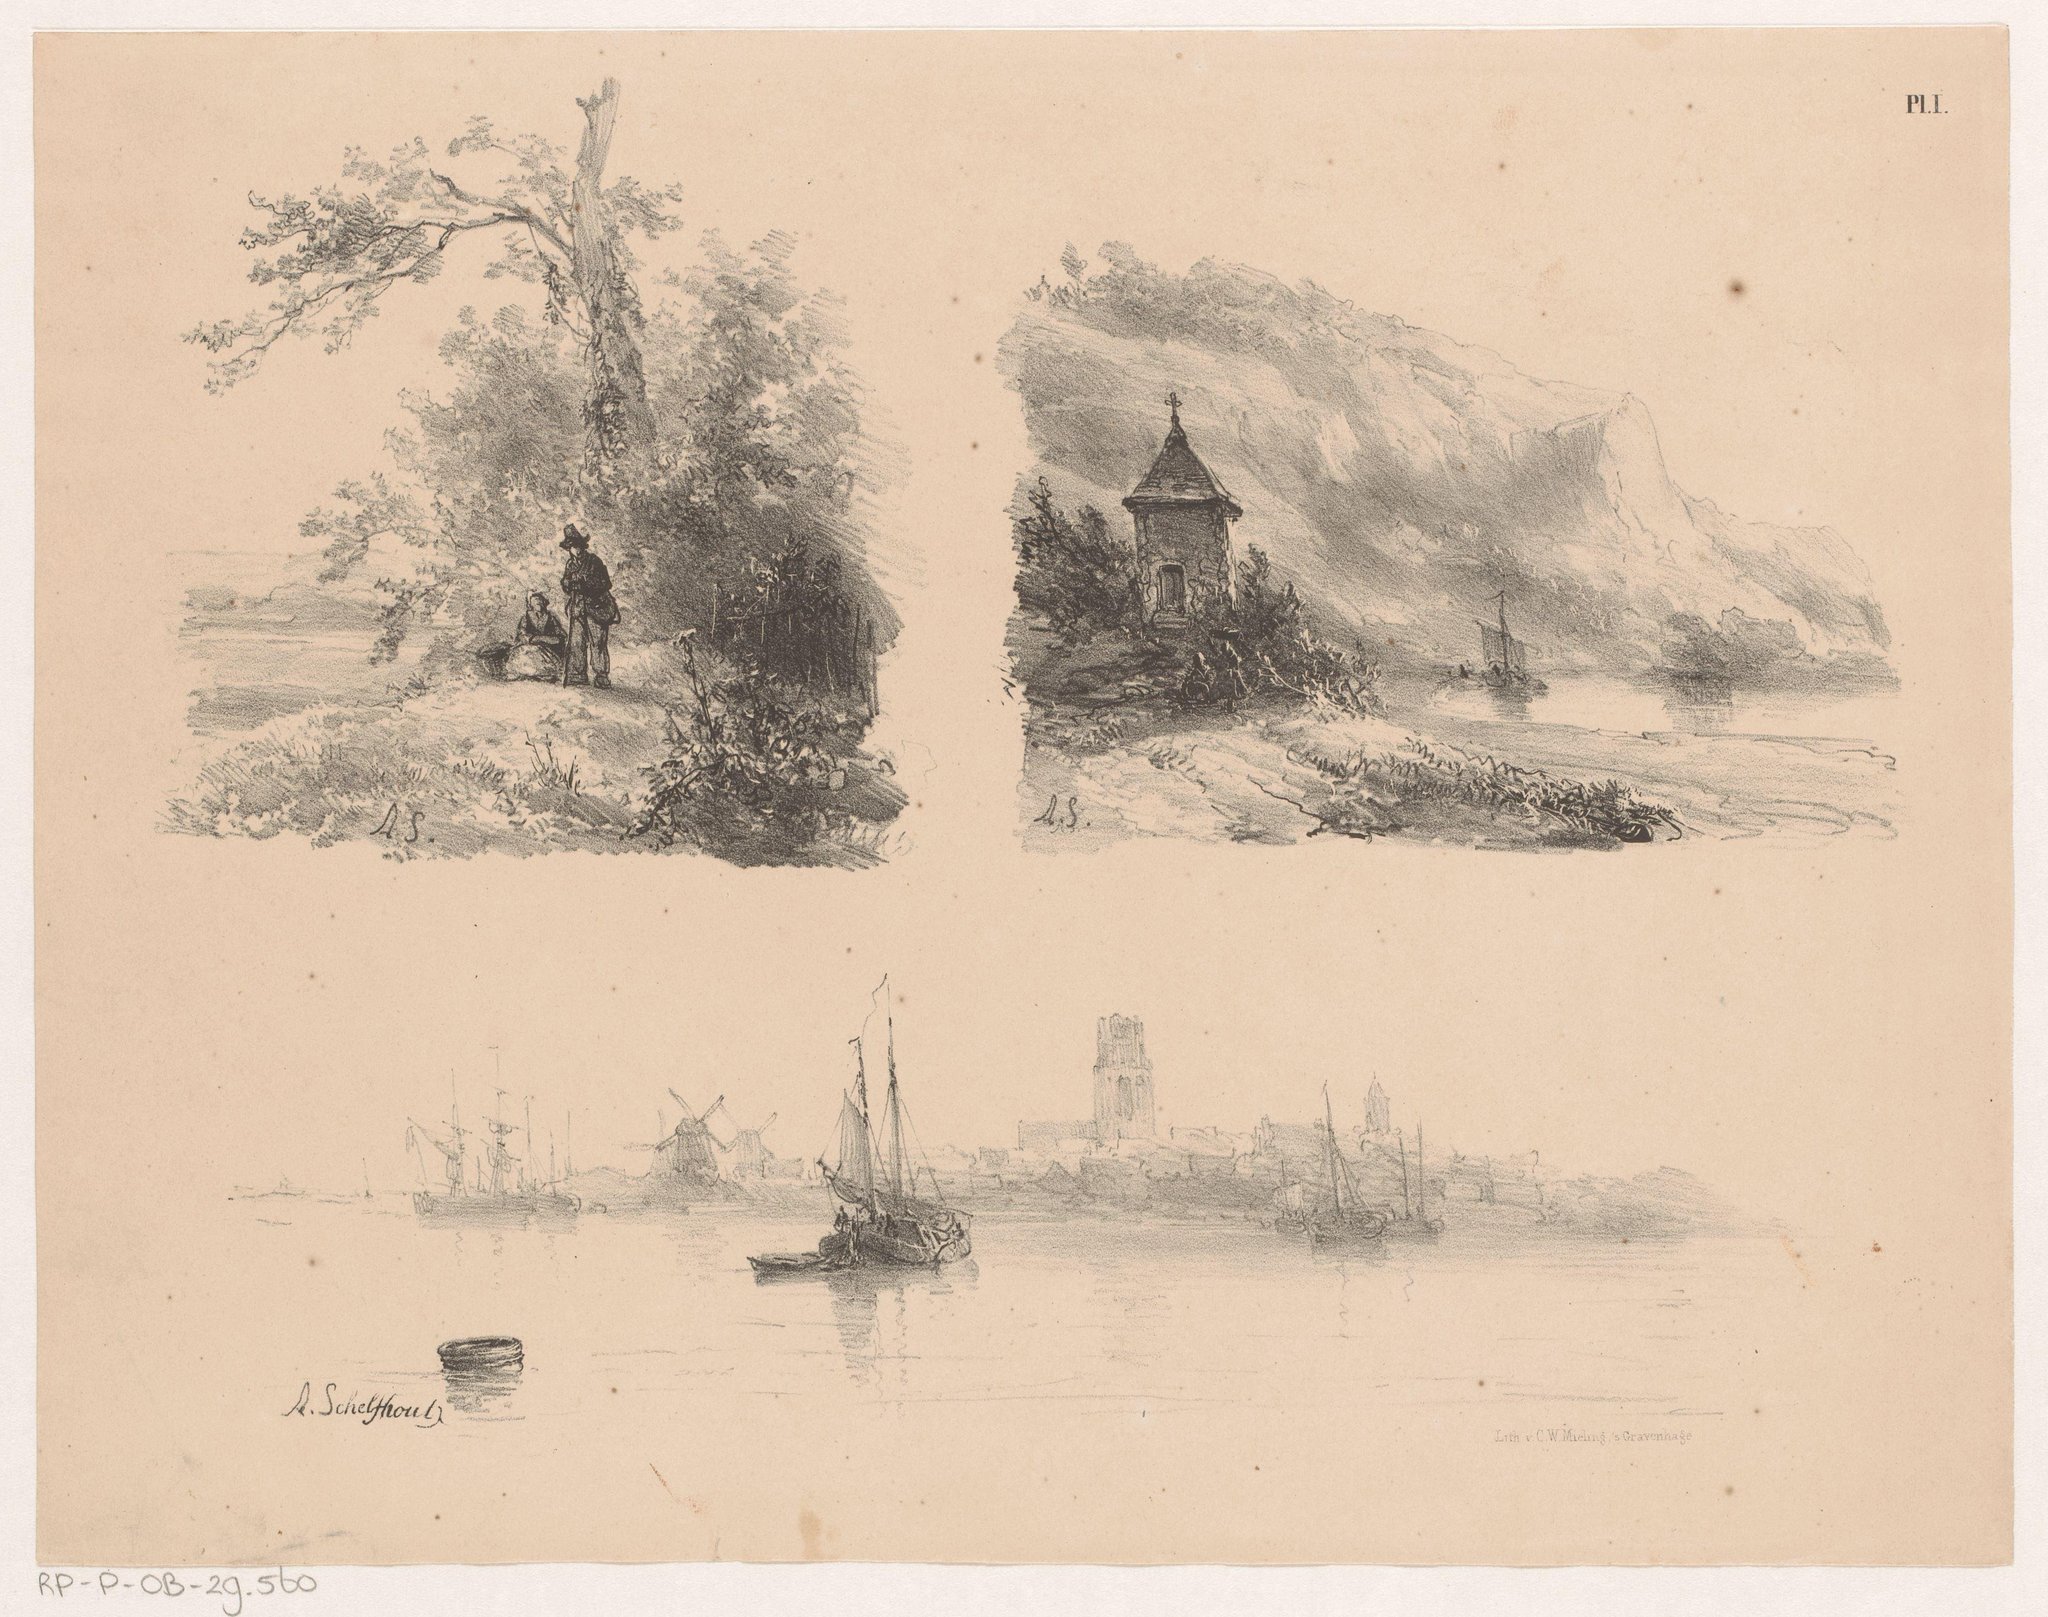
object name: print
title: Figuren in een bos, een rivier langs bergachtige kust en boten op het water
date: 1847-1865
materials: paper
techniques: lithograph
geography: the hague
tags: sailing-ship, sailing-boat, river, forest, wood, dordrecht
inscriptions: collector's mark: Lugt 2228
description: Drie voorstellingen op een blad. Links boven: Een man en vrouw op een heuvel in een bos. Rechts boven: Een rivier met zeilboot langs een bergachtige kust met toren. Onder: Zeilboten op het water met in de achtergrond de stad Dordrecht. Rechts boven genummerd Pl. I.